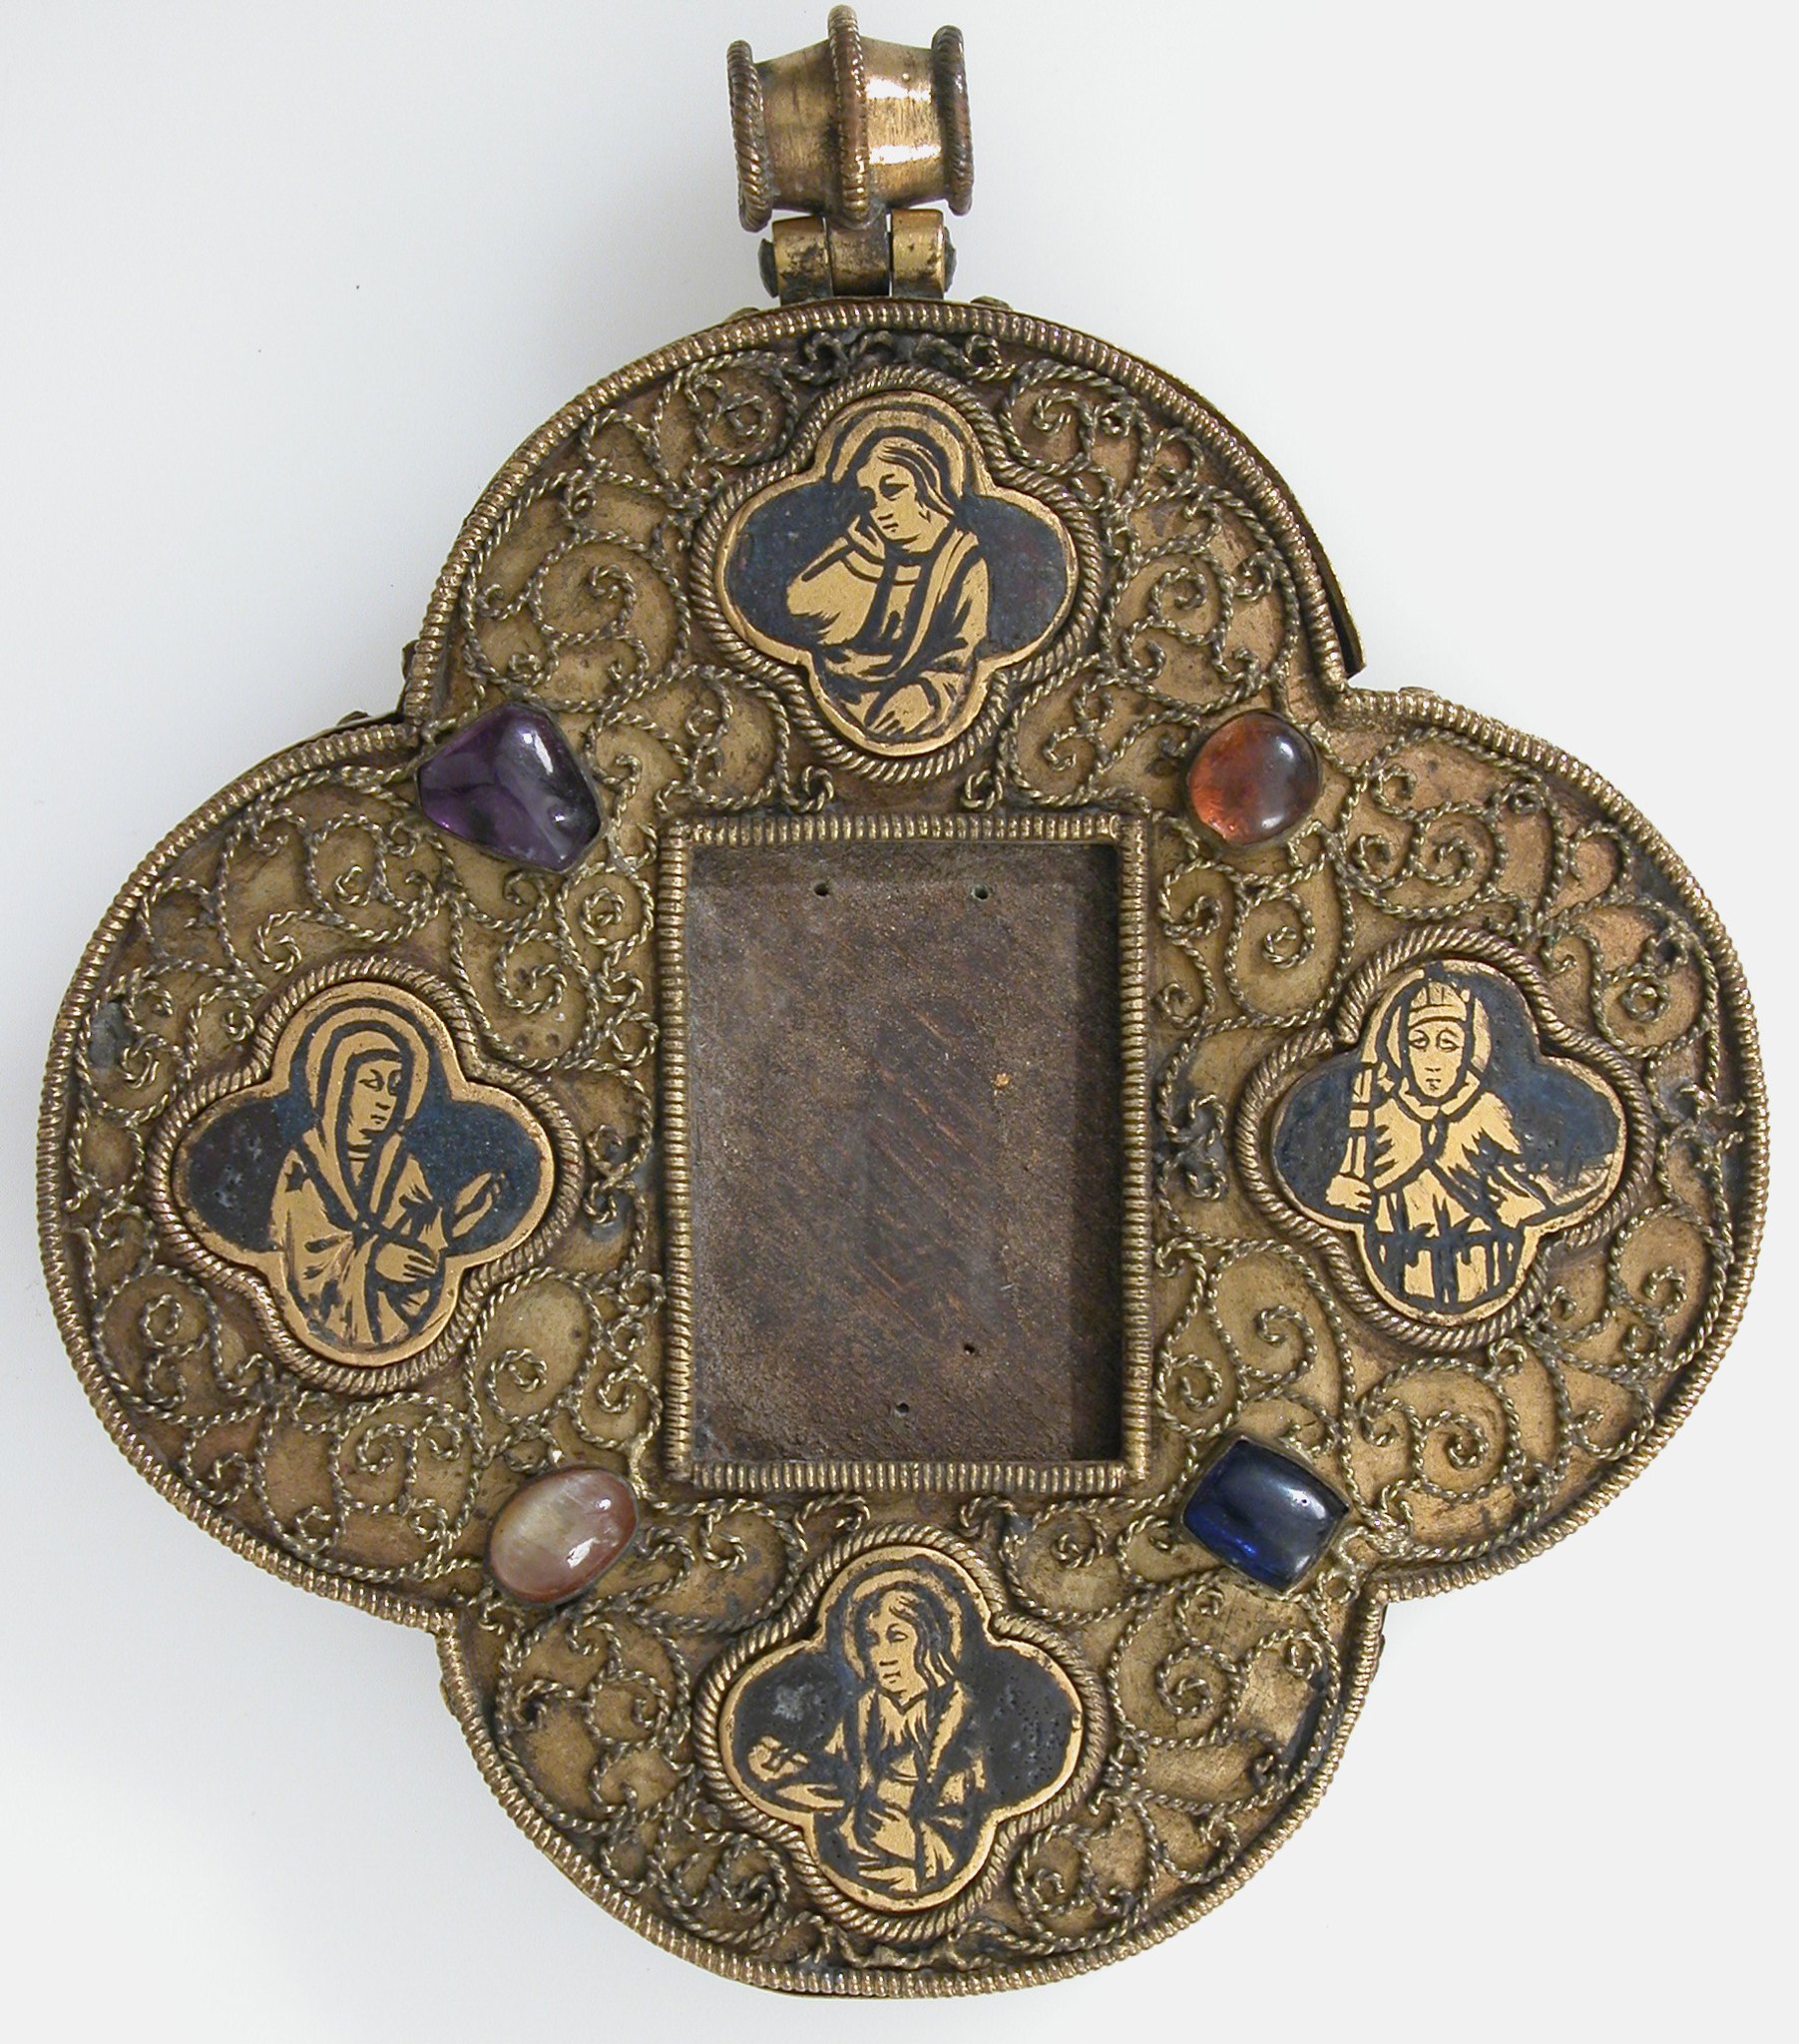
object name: quatrefoil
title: Quatrefoil Mount for a Medieval Ivory of the Crucifixion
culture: european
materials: enamel, glass, silver gilt, stone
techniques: enamel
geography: germany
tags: virgin mary,saints